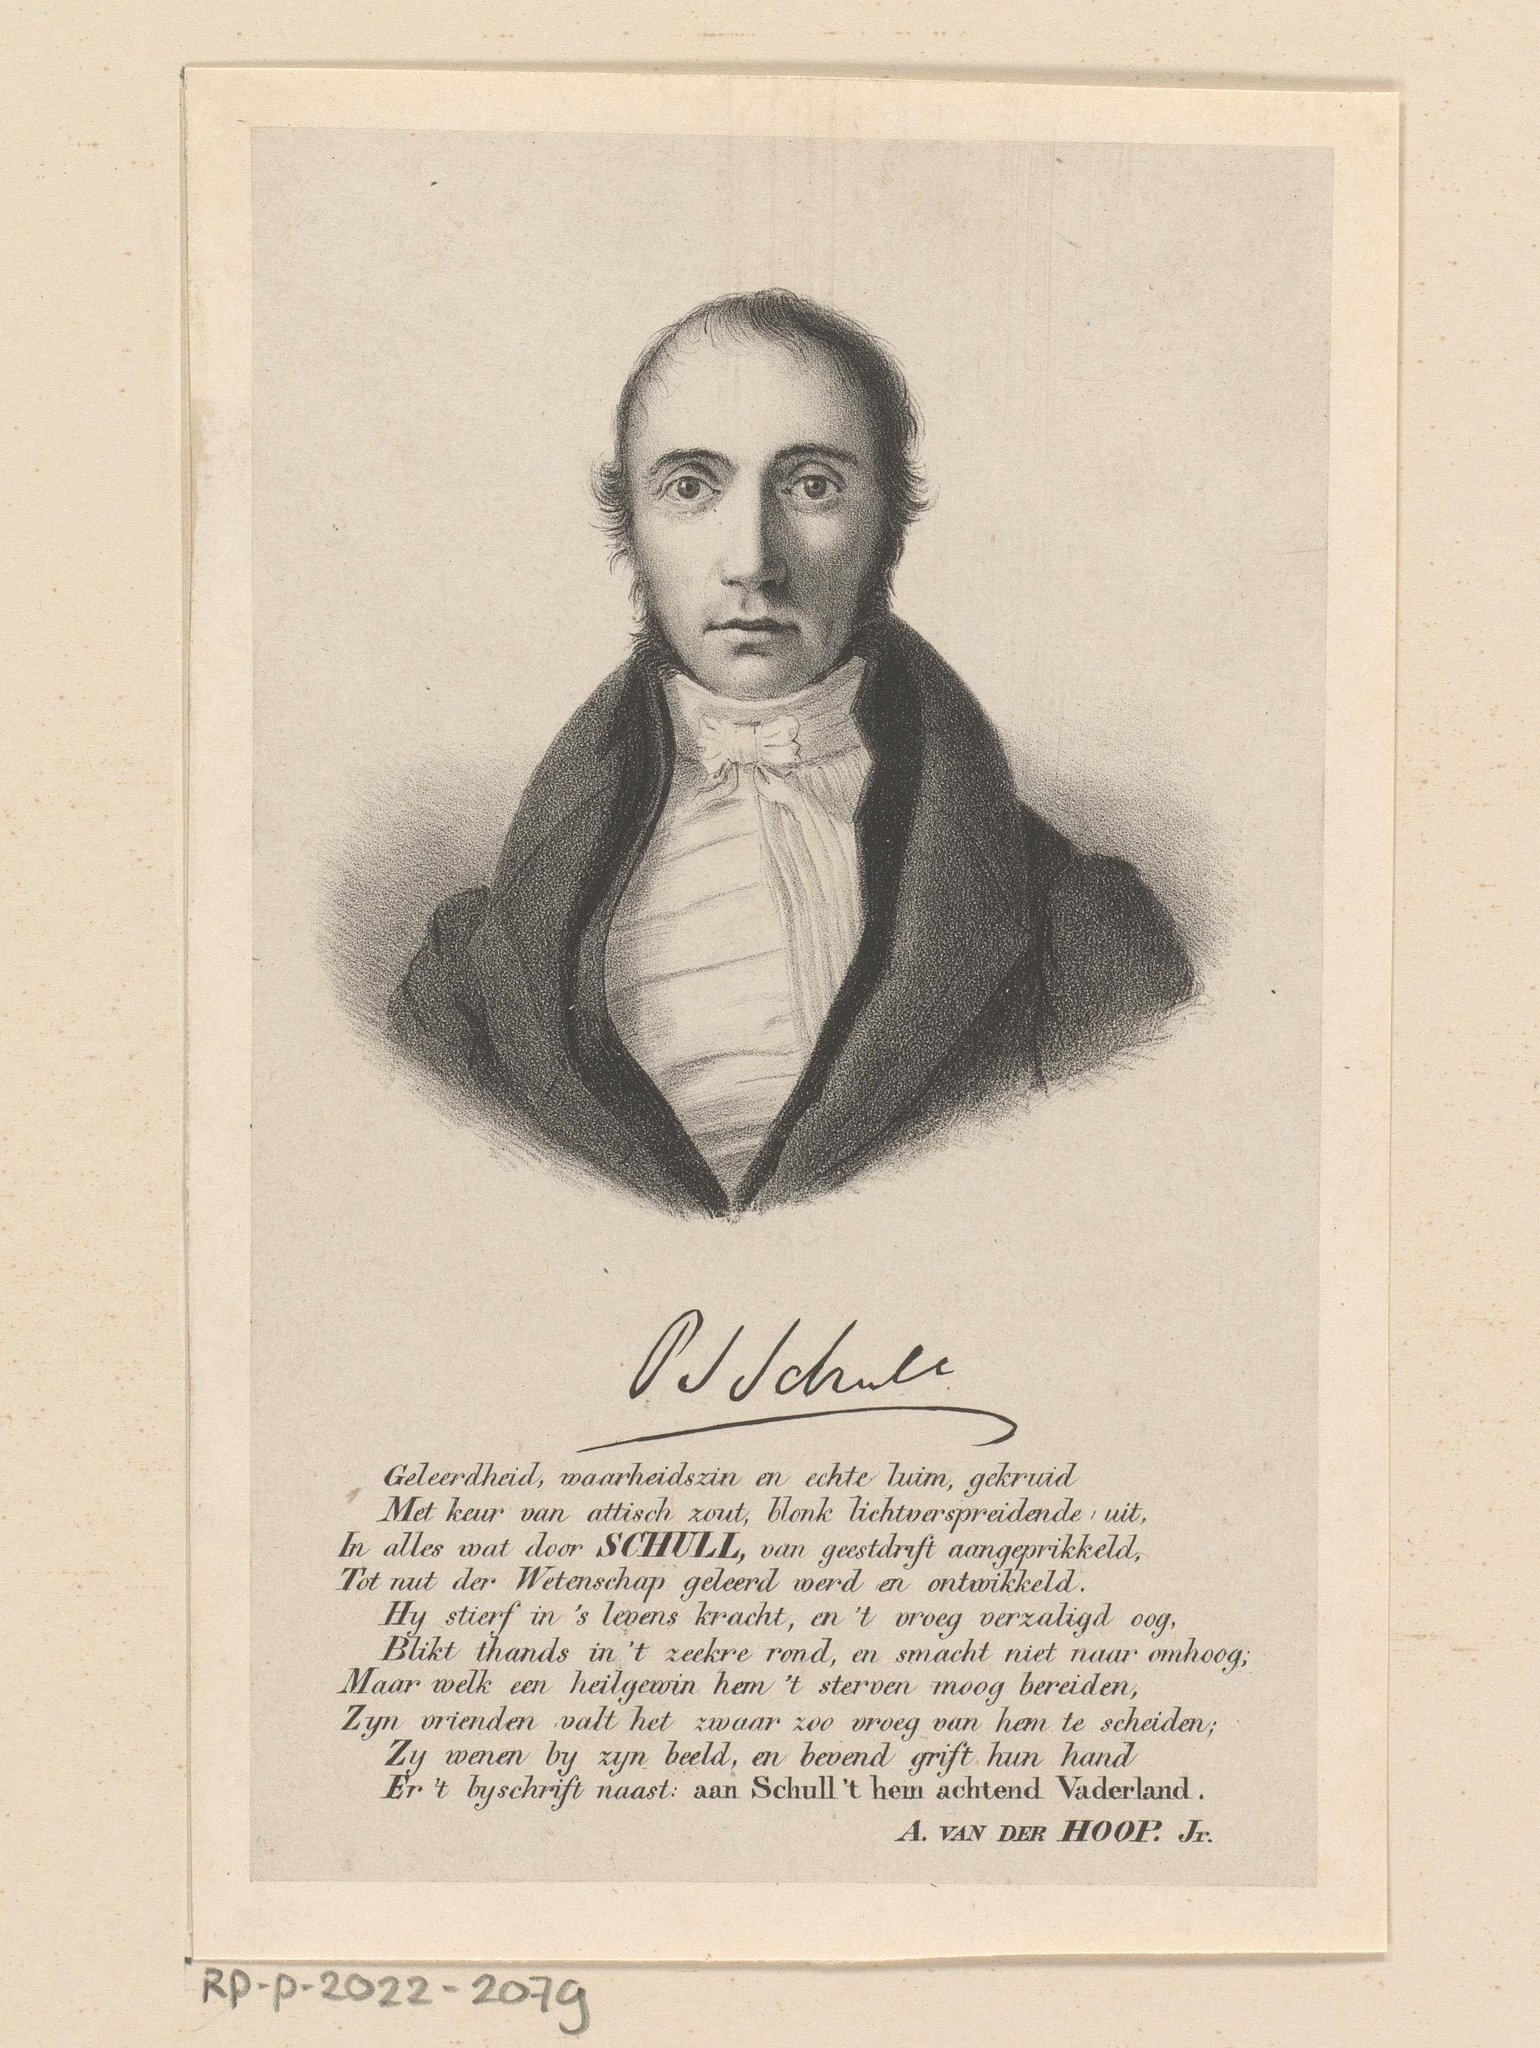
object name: print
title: Portret van Peter Steven Schull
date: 1835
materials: paper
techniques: lithograph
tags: historical persons, portrait of a writer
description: Prent waarschijnlijk uit: Schull, Petrus Steven en Jacob Cornelis van Rijneveld. Boog-ontspanning. Dordrecht: Johannes van Houtrijve, 1835.